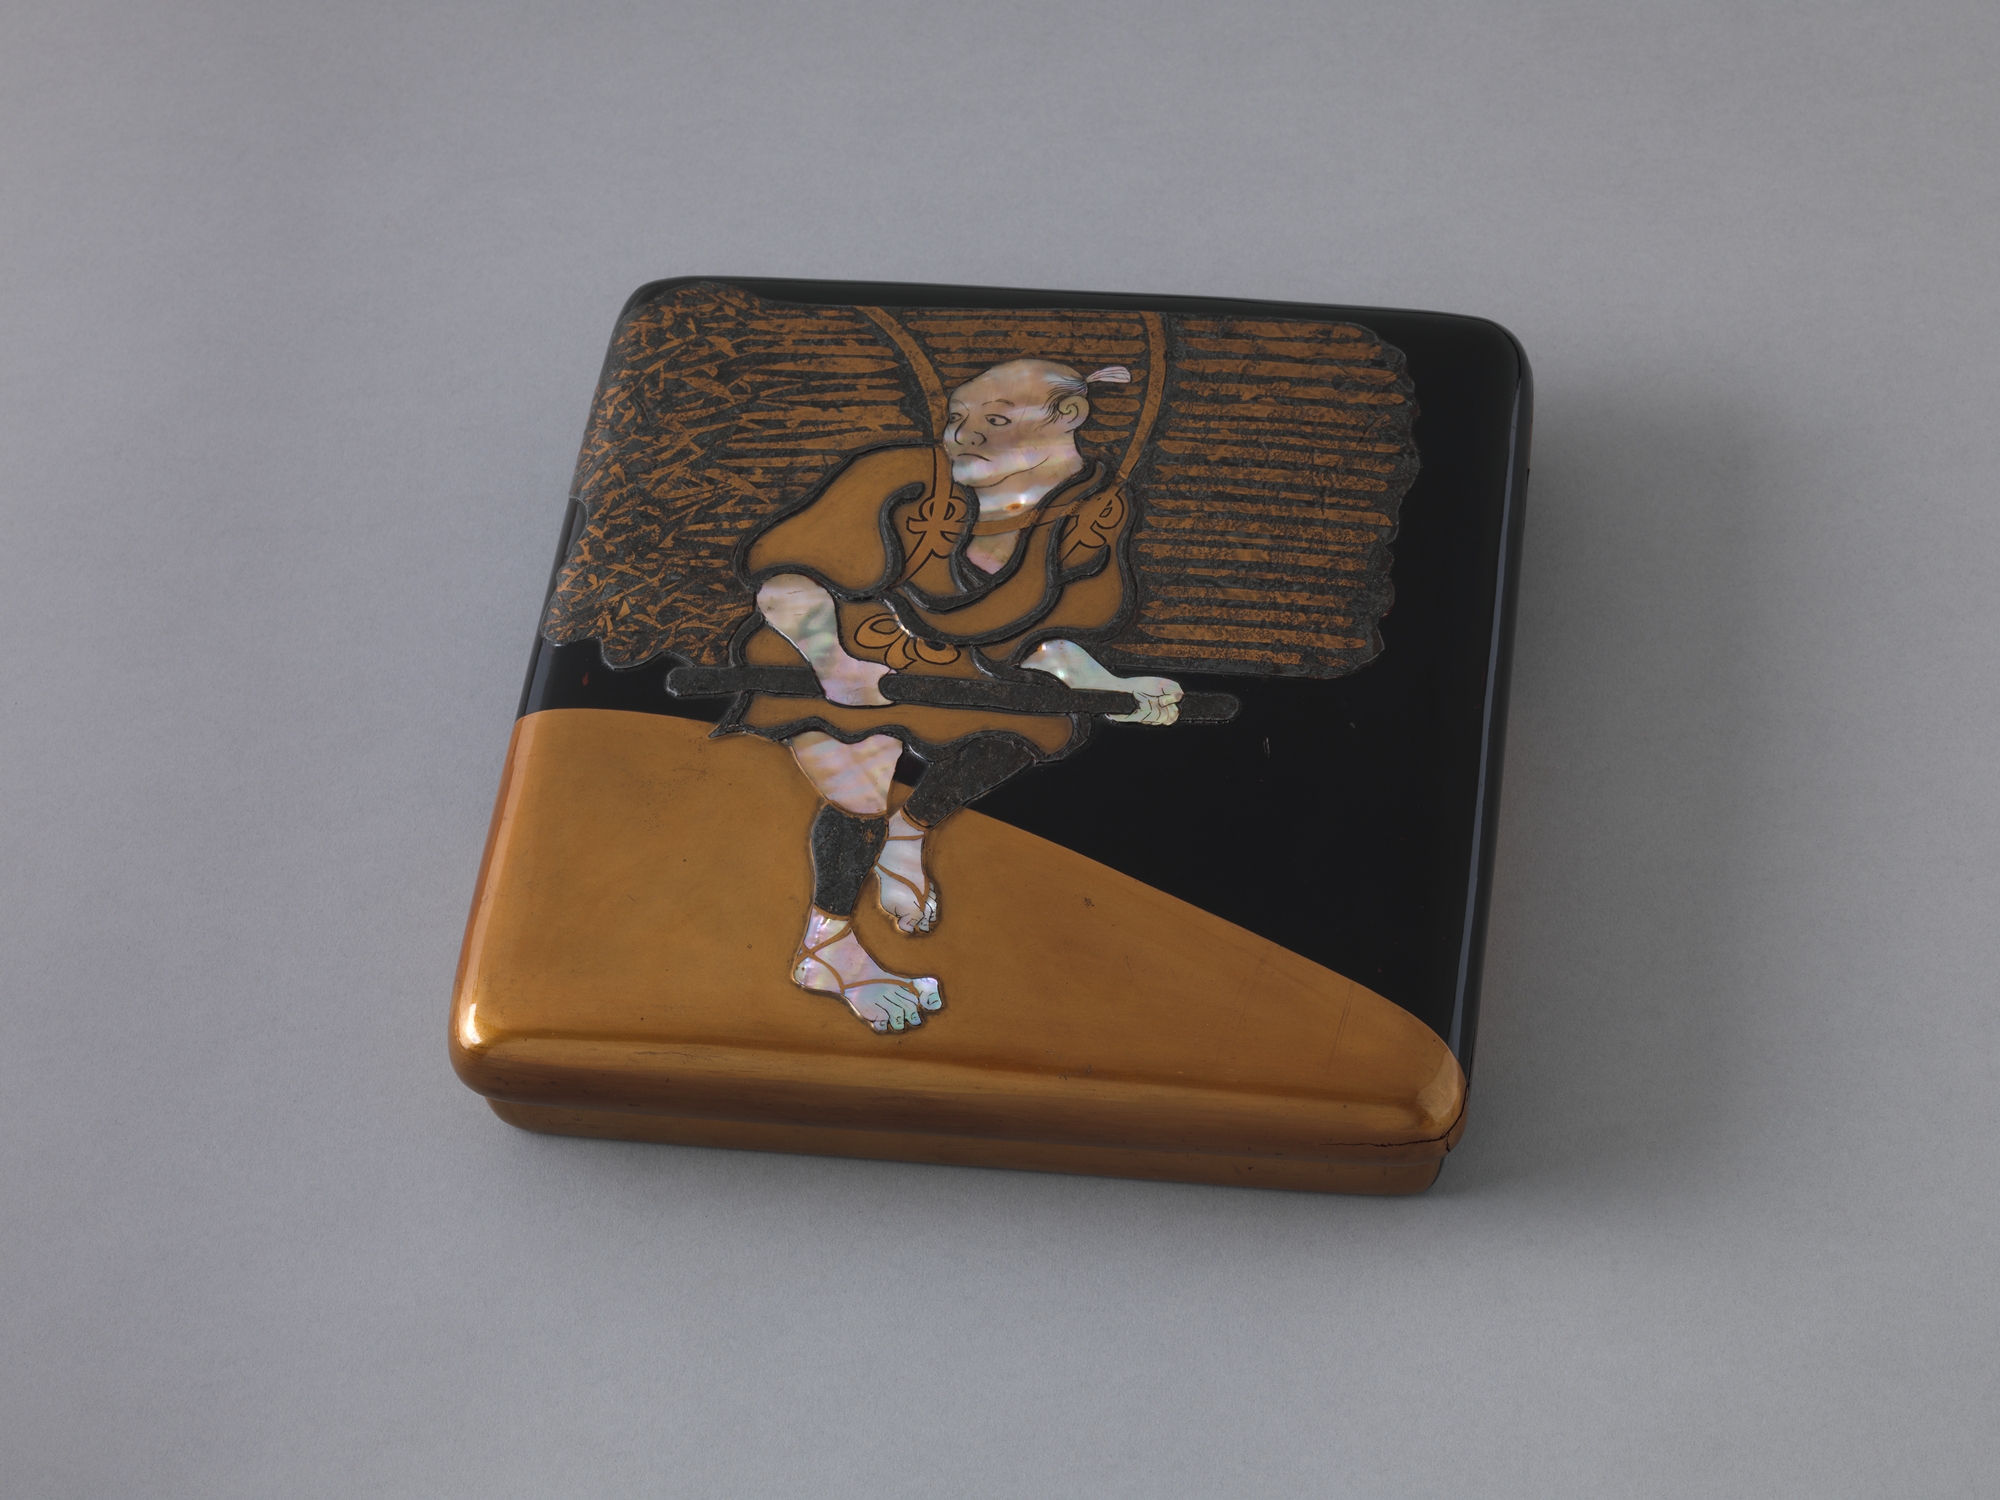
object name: writing box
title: Writing Box with Woodcutter Design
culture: japanese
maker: ogata kōrin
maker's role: artist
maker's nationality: japanese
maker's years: 1658-1716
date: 1801-1900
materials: gold, lacquer, mother of pearl, pewter, wood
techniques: inlay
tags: men